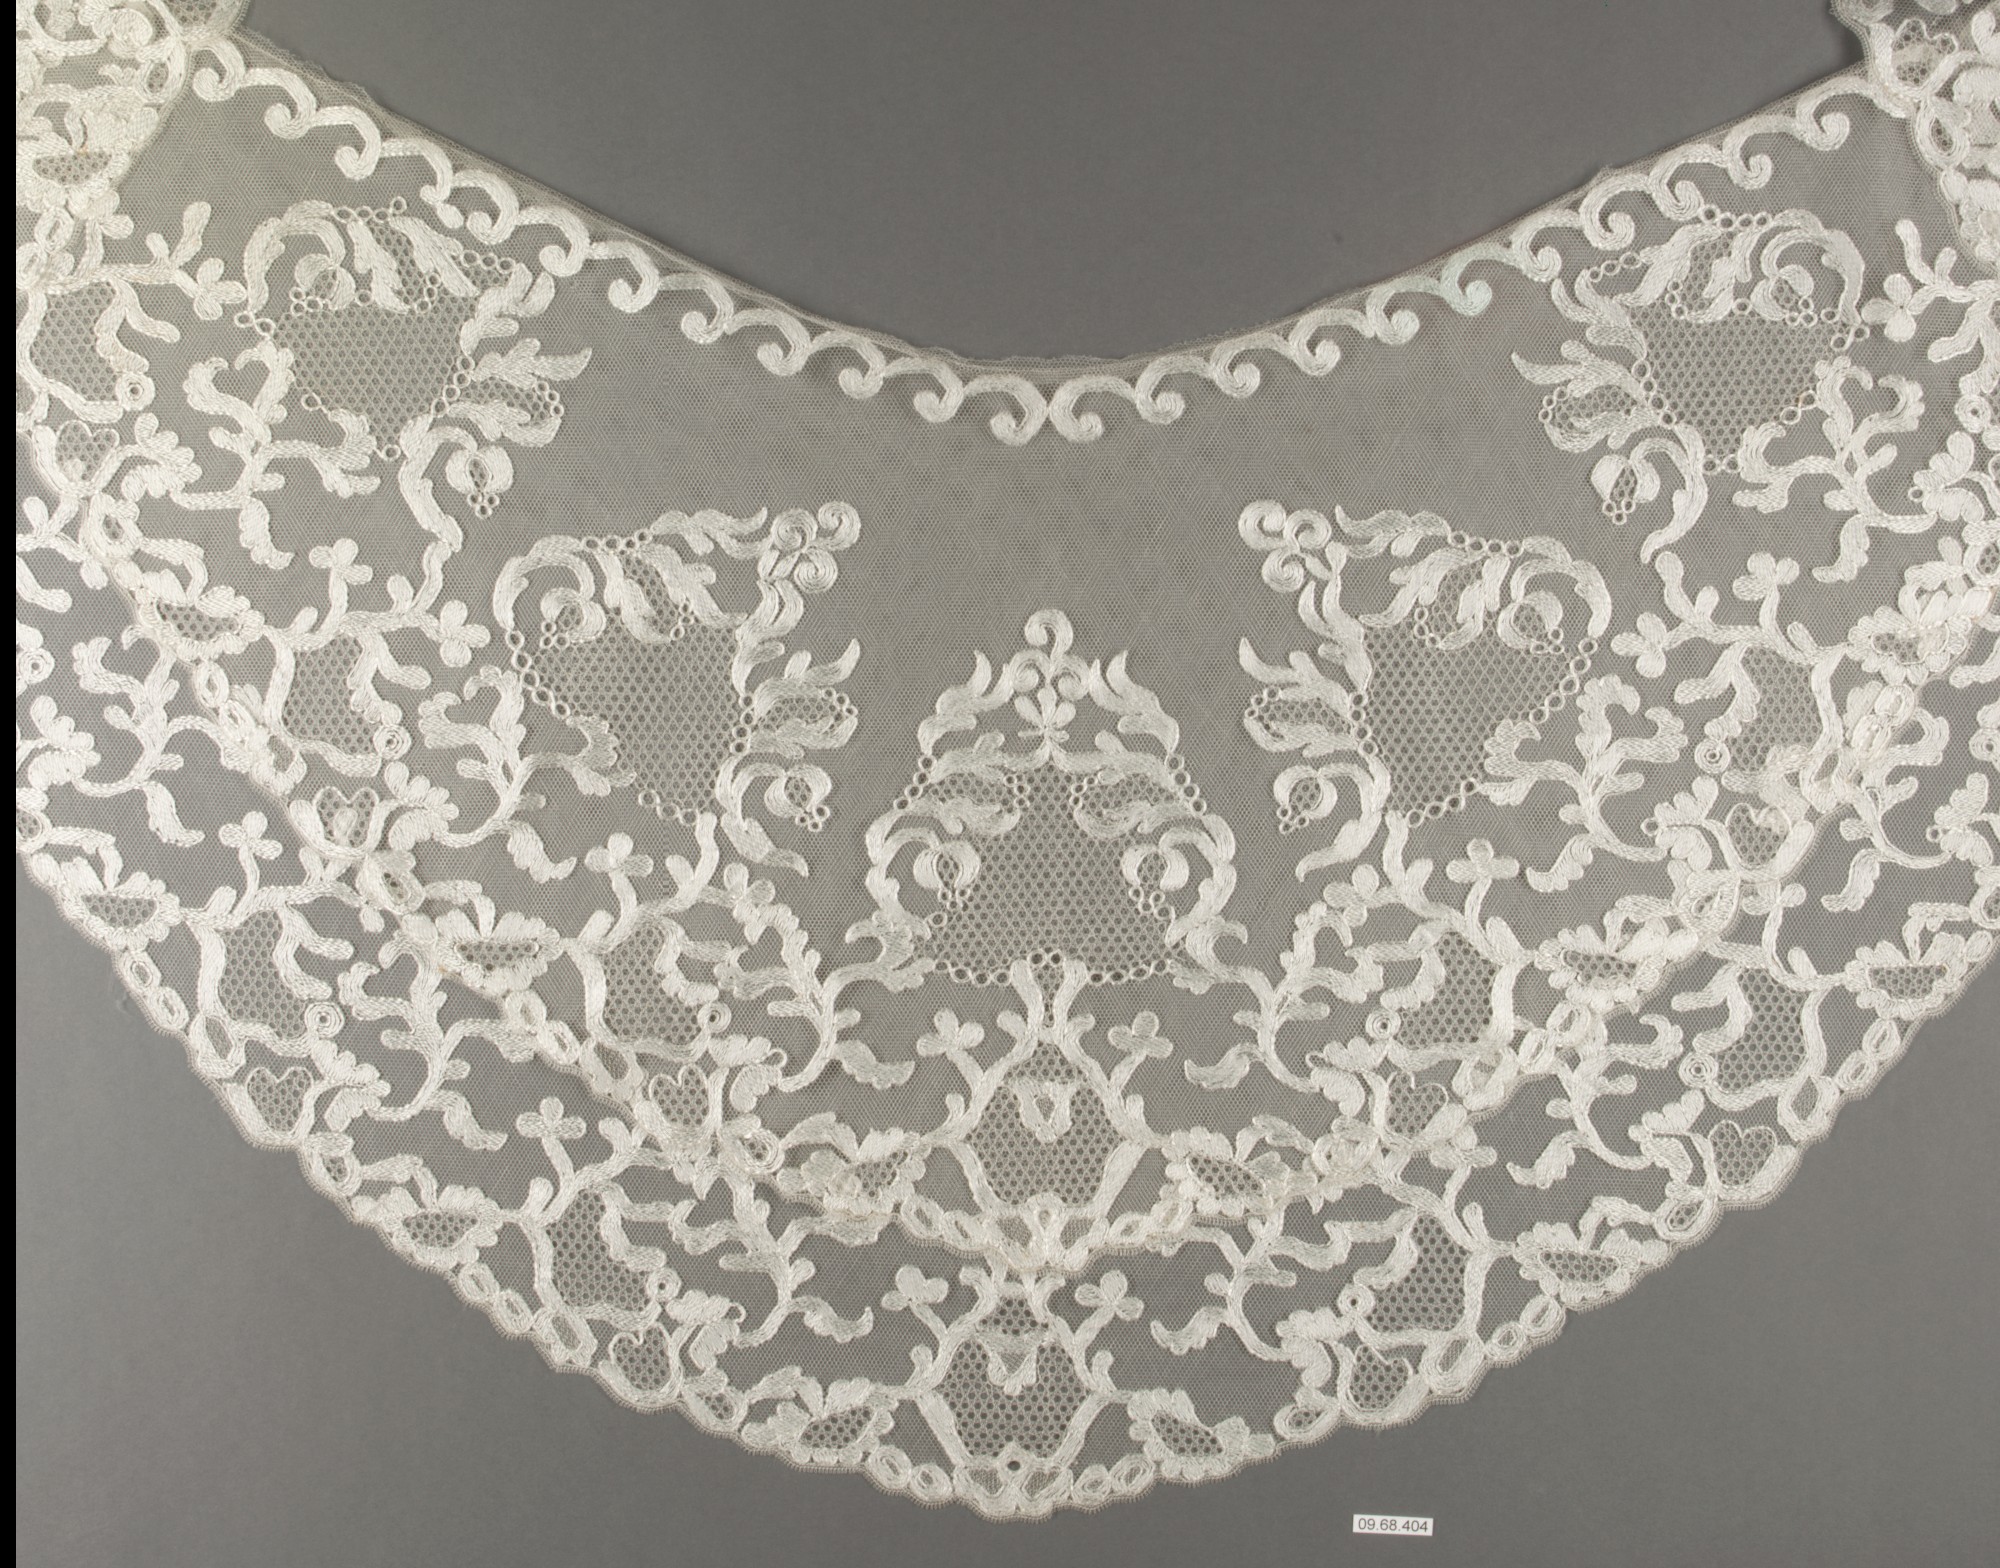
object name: pelerine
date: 1801-1900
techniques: lace